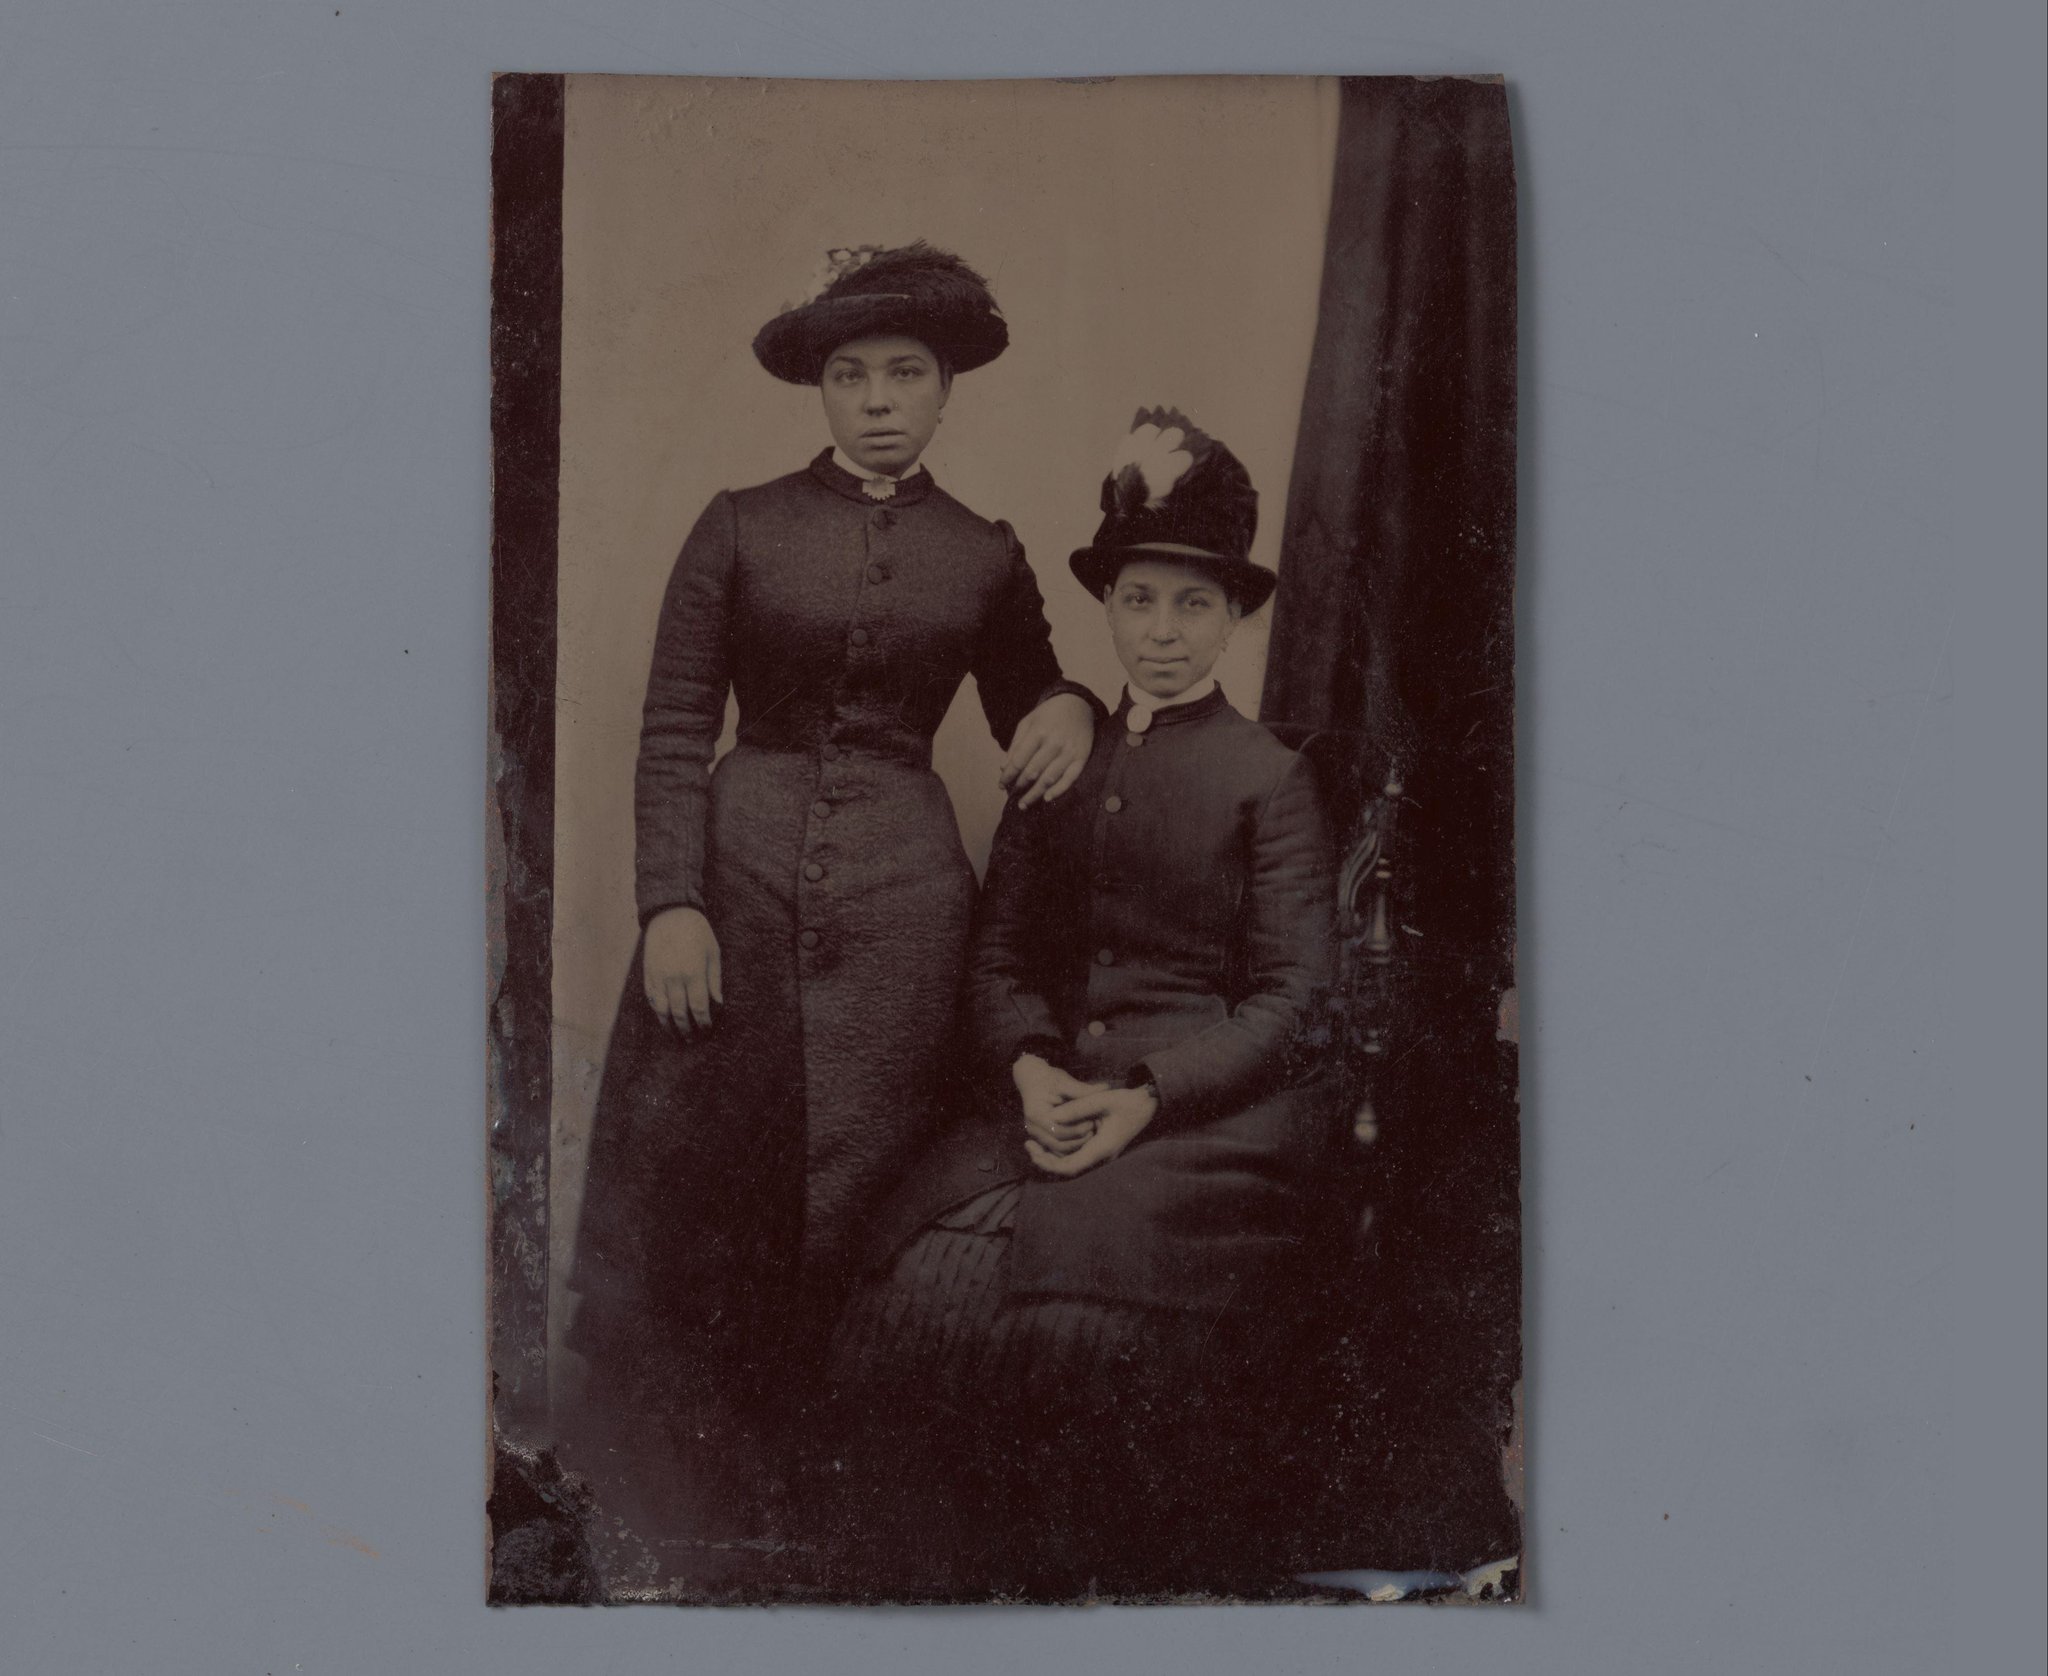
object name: photograph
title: Portrait of two unknown young women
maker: Anonymous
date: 1855-1940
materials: iron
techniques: ferrotyping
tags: historical persons - bb - woman, head-gear: hat, adolescent, young woman, maiden (+ two persons)